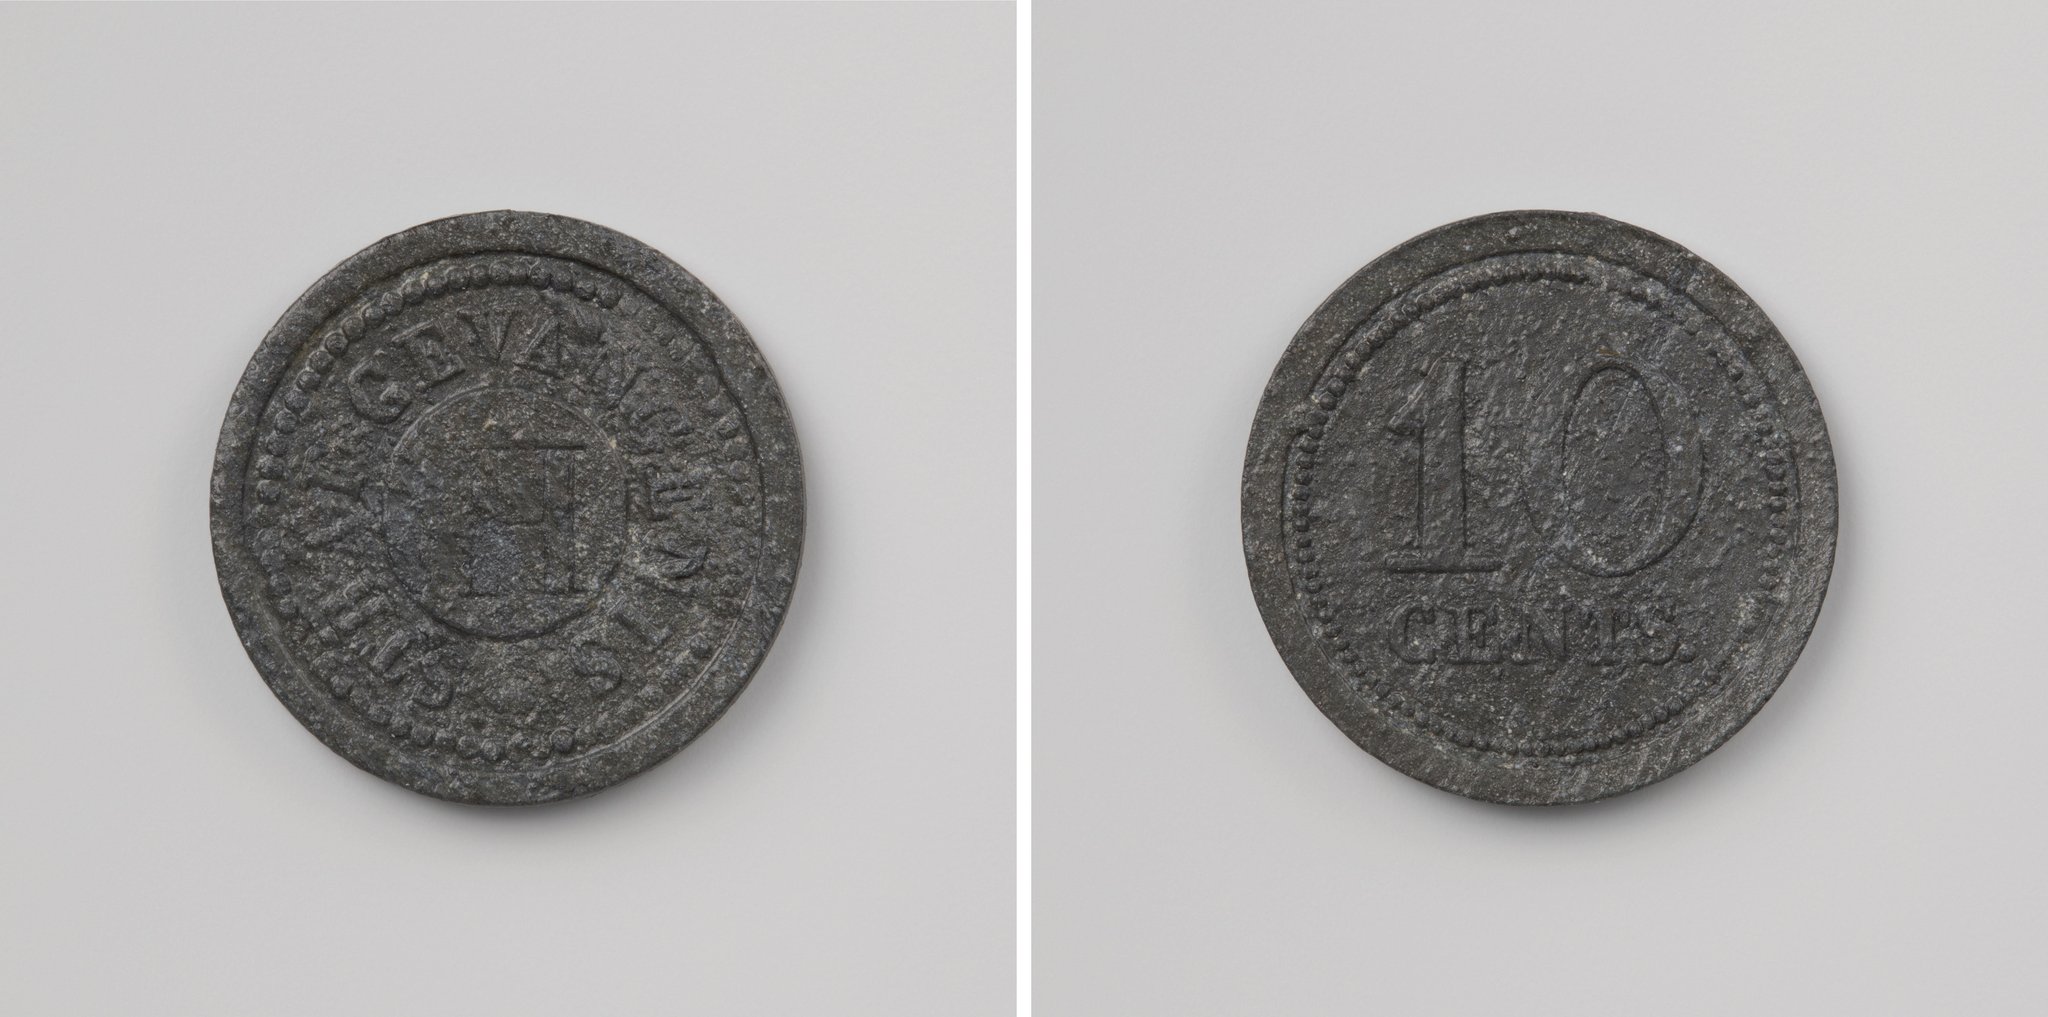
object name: monetary token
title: Strafgevangenis te Hoorn, huismunt ter waarde van tien cents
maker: Anonymous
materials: zinc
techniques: striking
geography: utrecht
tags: hoorn (north holland)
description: Zinken betaalpenning. Voorzijde: letter H binnen omschrift. Keerzijde: waardeaanduiding